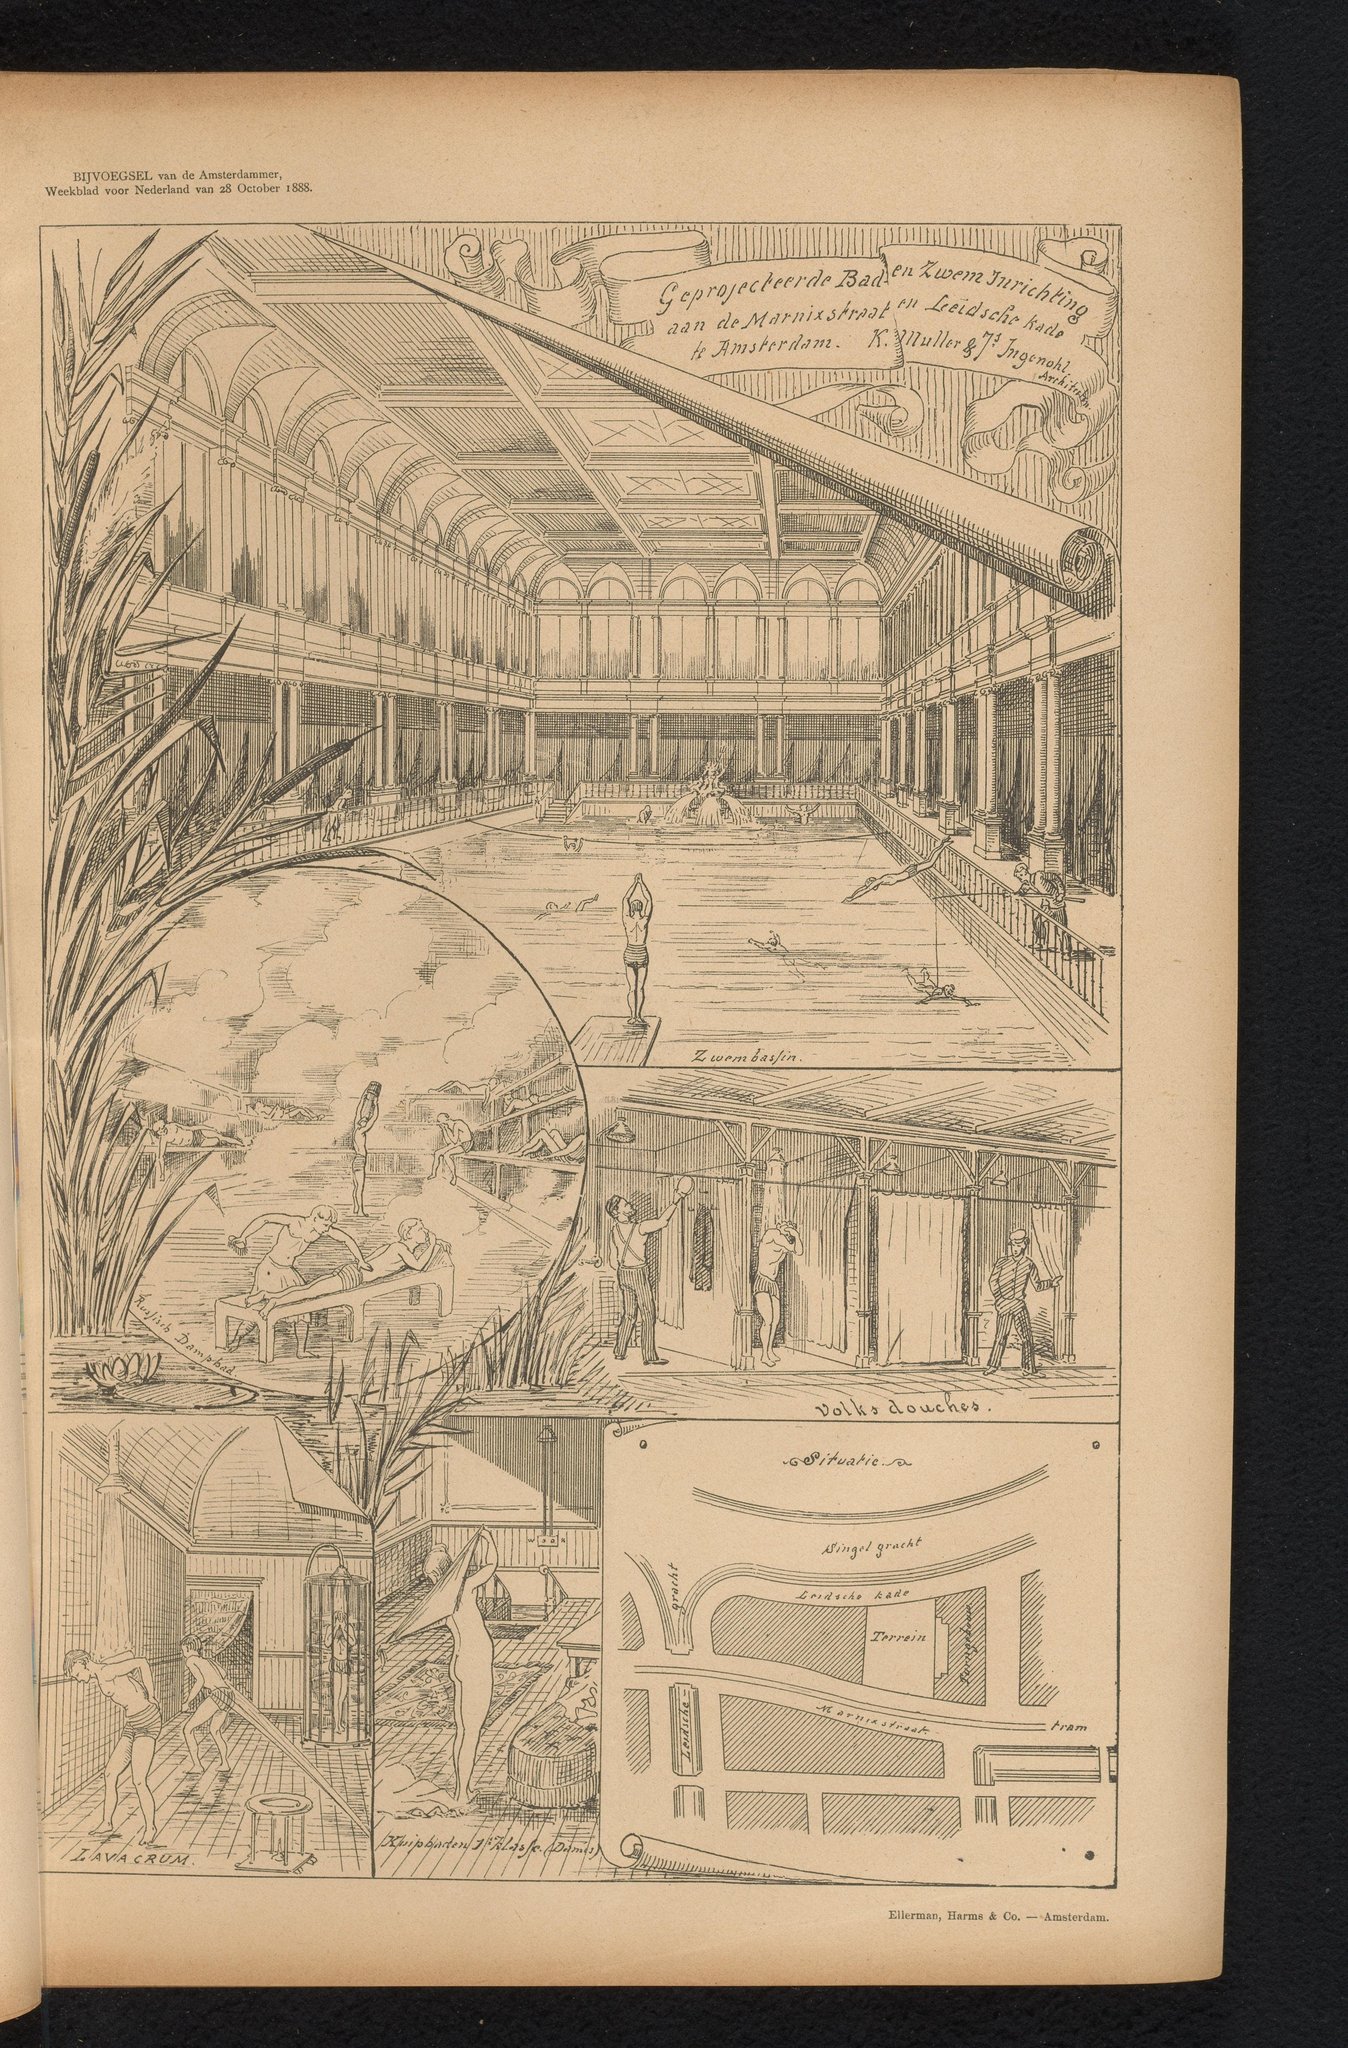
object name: print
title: Geprojecteerde bad- en zweminrichting aan de Marnixstraat en Leidsekade te Amsterdam. K. Muller & Js. Ingenohl architecten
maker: Anonymous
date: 1888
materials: paper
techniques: lithograph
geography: netherlands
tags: shower, public baths, swimming (sport), architectural design or model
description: Bouwtekening met impressies van het zwembad aan de Marnixstraat en Leidsekade in Amsterdam, van de architecten K. Muller & Js. Ingenohl. Niet uitgevoerd.